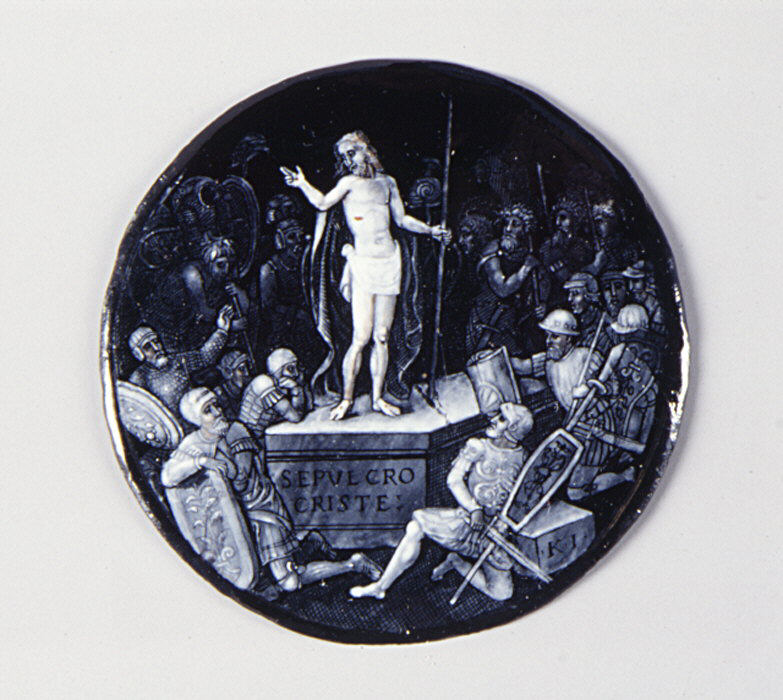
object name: medallion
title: The Resurrection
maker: master k.i.p.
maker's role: artist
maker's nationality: french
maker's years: 1530-1565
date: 1534-1566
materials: copper, enamel, gilt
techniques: painting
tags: soldiers,christ